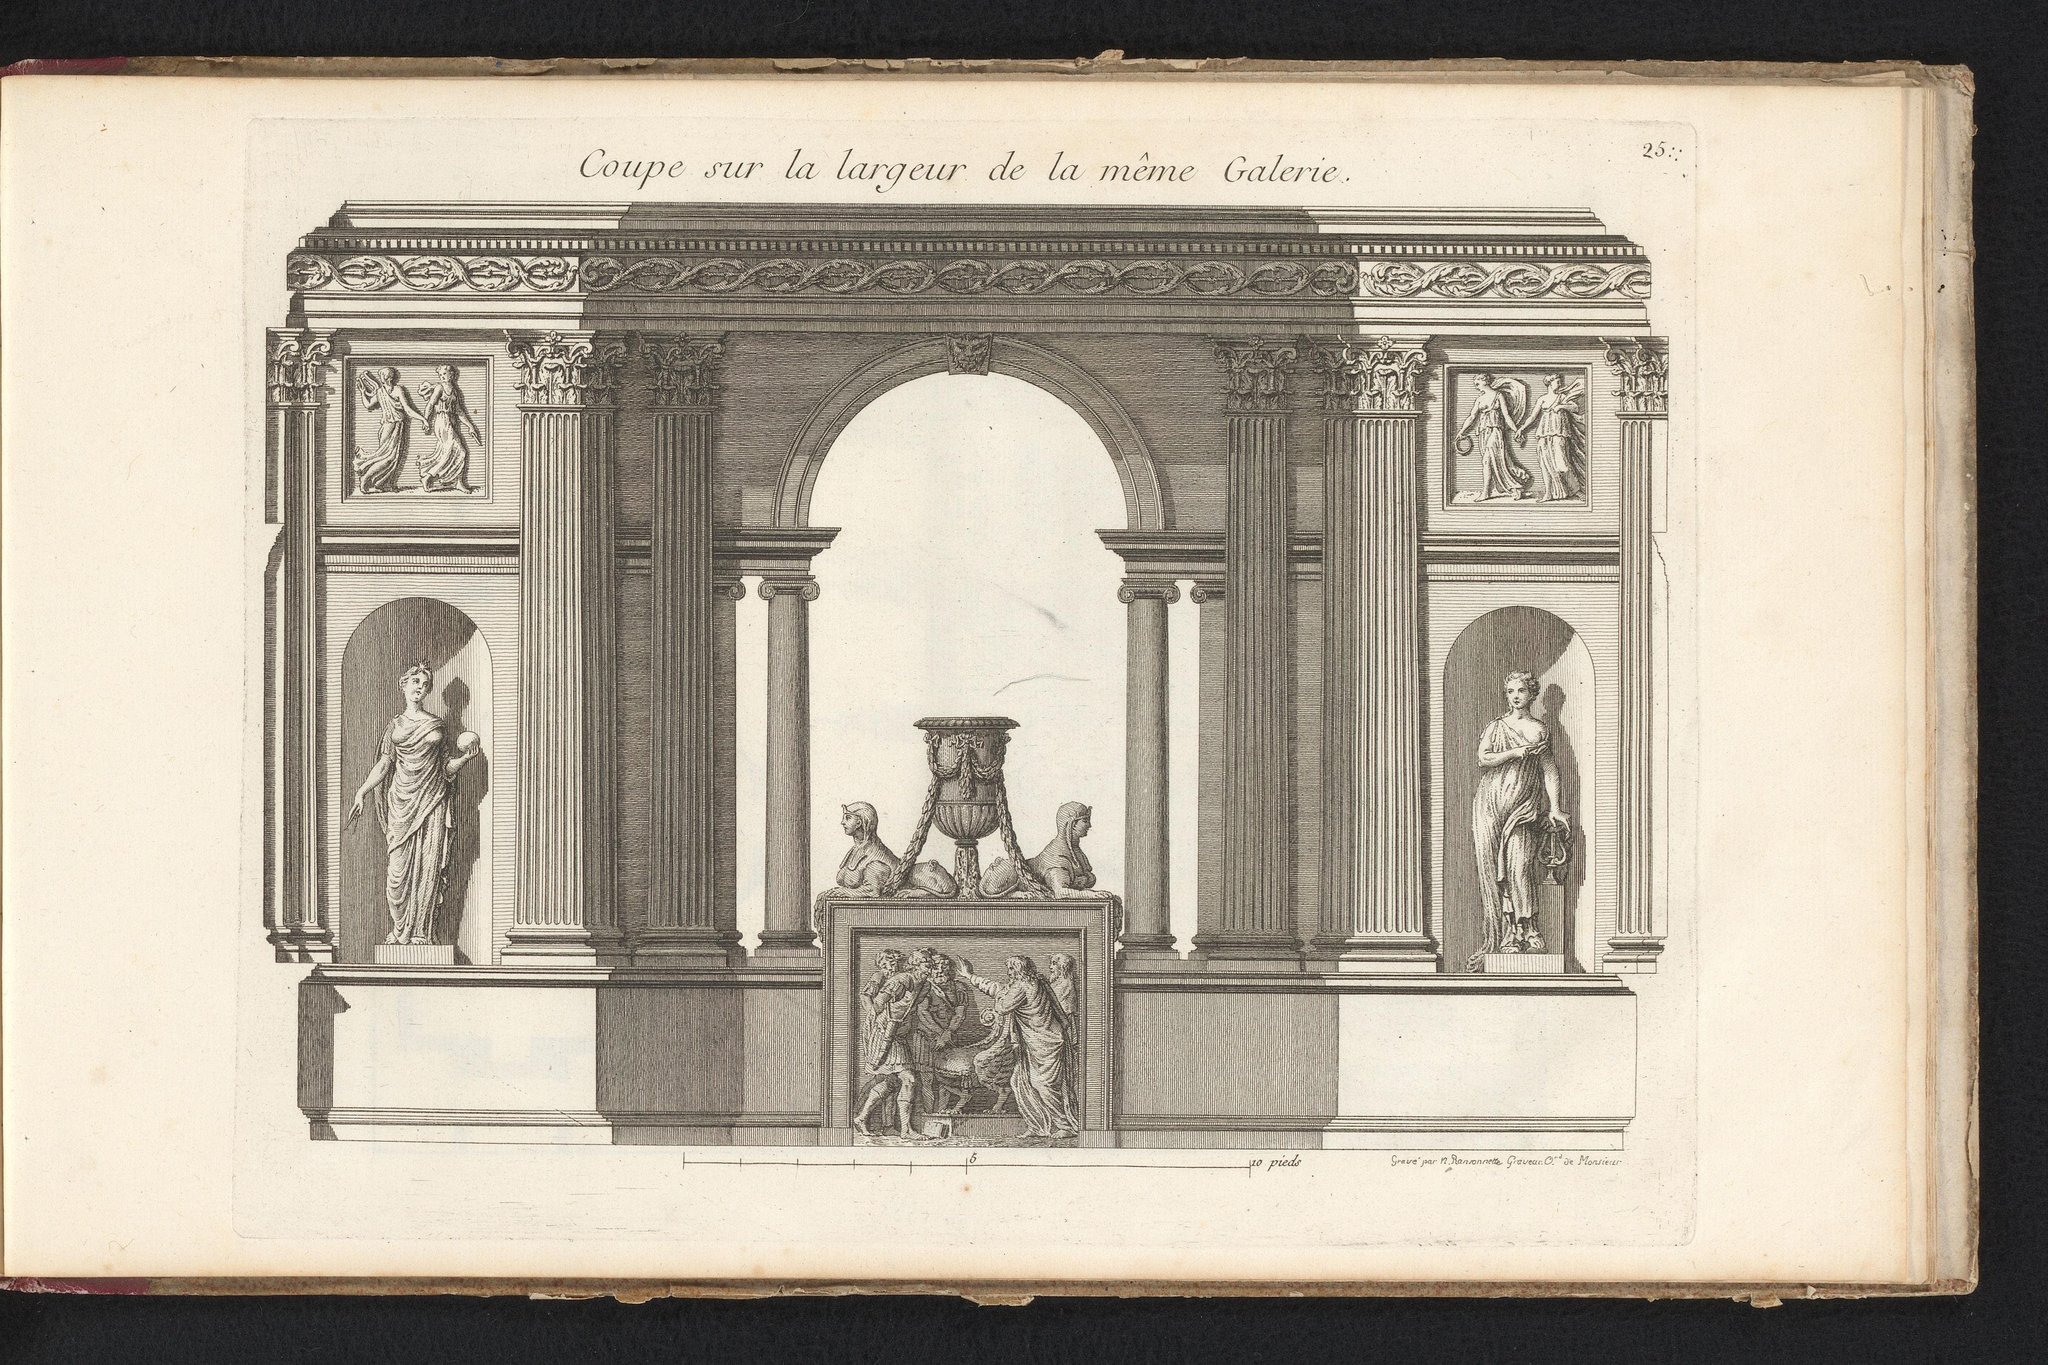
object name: album leaf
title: Coupe sur la largeur de la même galerie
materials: paper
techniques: engraving, etching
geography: paris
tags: gallery of sculptures, statues, sculptures in garden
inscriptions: collector's mark: Lugt 2228, collector's mark: Lugt 2760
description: De serie 'Jardins anglo-chinois à la mode' verscheen in totaal in 21 zogeheten 'cahiers' (afleveringen). De huidige prent komt uit het vierde 'cahier'. Het Rijksmuseum Amsterdam bezit drie banden met daarin in totaal zes 'cahiers' van deze reeks. In de documentatie wordt verwezen naar een in de bibliotheek van het Rijksmuseum Amsterdam aanwezige facsimile van het complete werk.